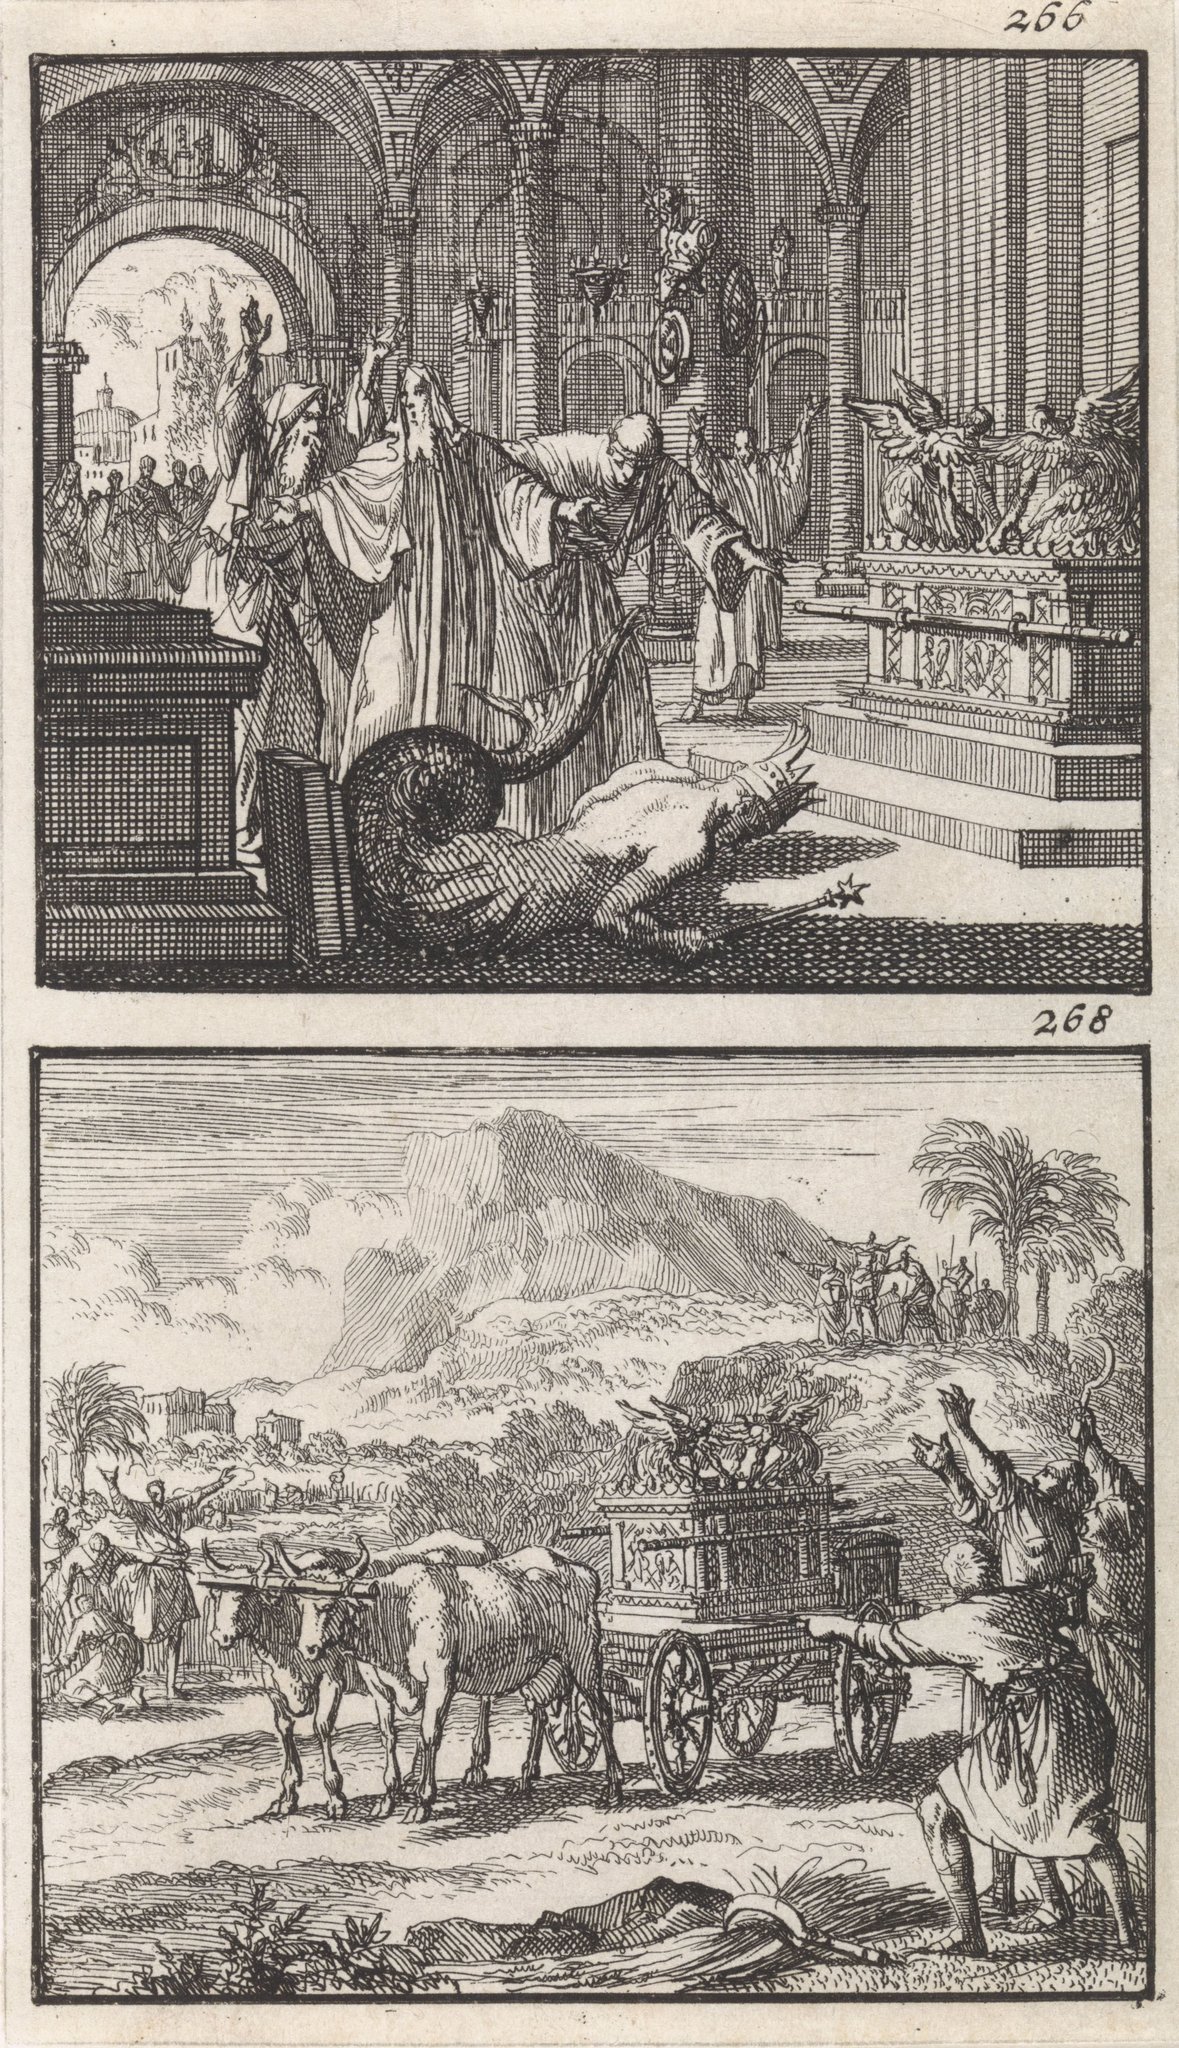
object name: book illustration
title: Ark des Verbonds in de tempel van Dagon / Terugkeer van de Ark des Verbonds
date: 1698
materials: paper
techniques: etching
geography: amsterdam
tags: the ark of the covenant returned to israel, the statue of dagon in ashdod falls down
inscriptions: collector's mark: Lugt 2228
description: Illustratie uit: Josephus, Flavius. XX. boeken van de oude geschiedenissen der joden, 4 delen. Amsterdam: Barent Visscher, Willem de Coup, Willem van Lamsveld, Andries van Damme, 1698, dl. I.